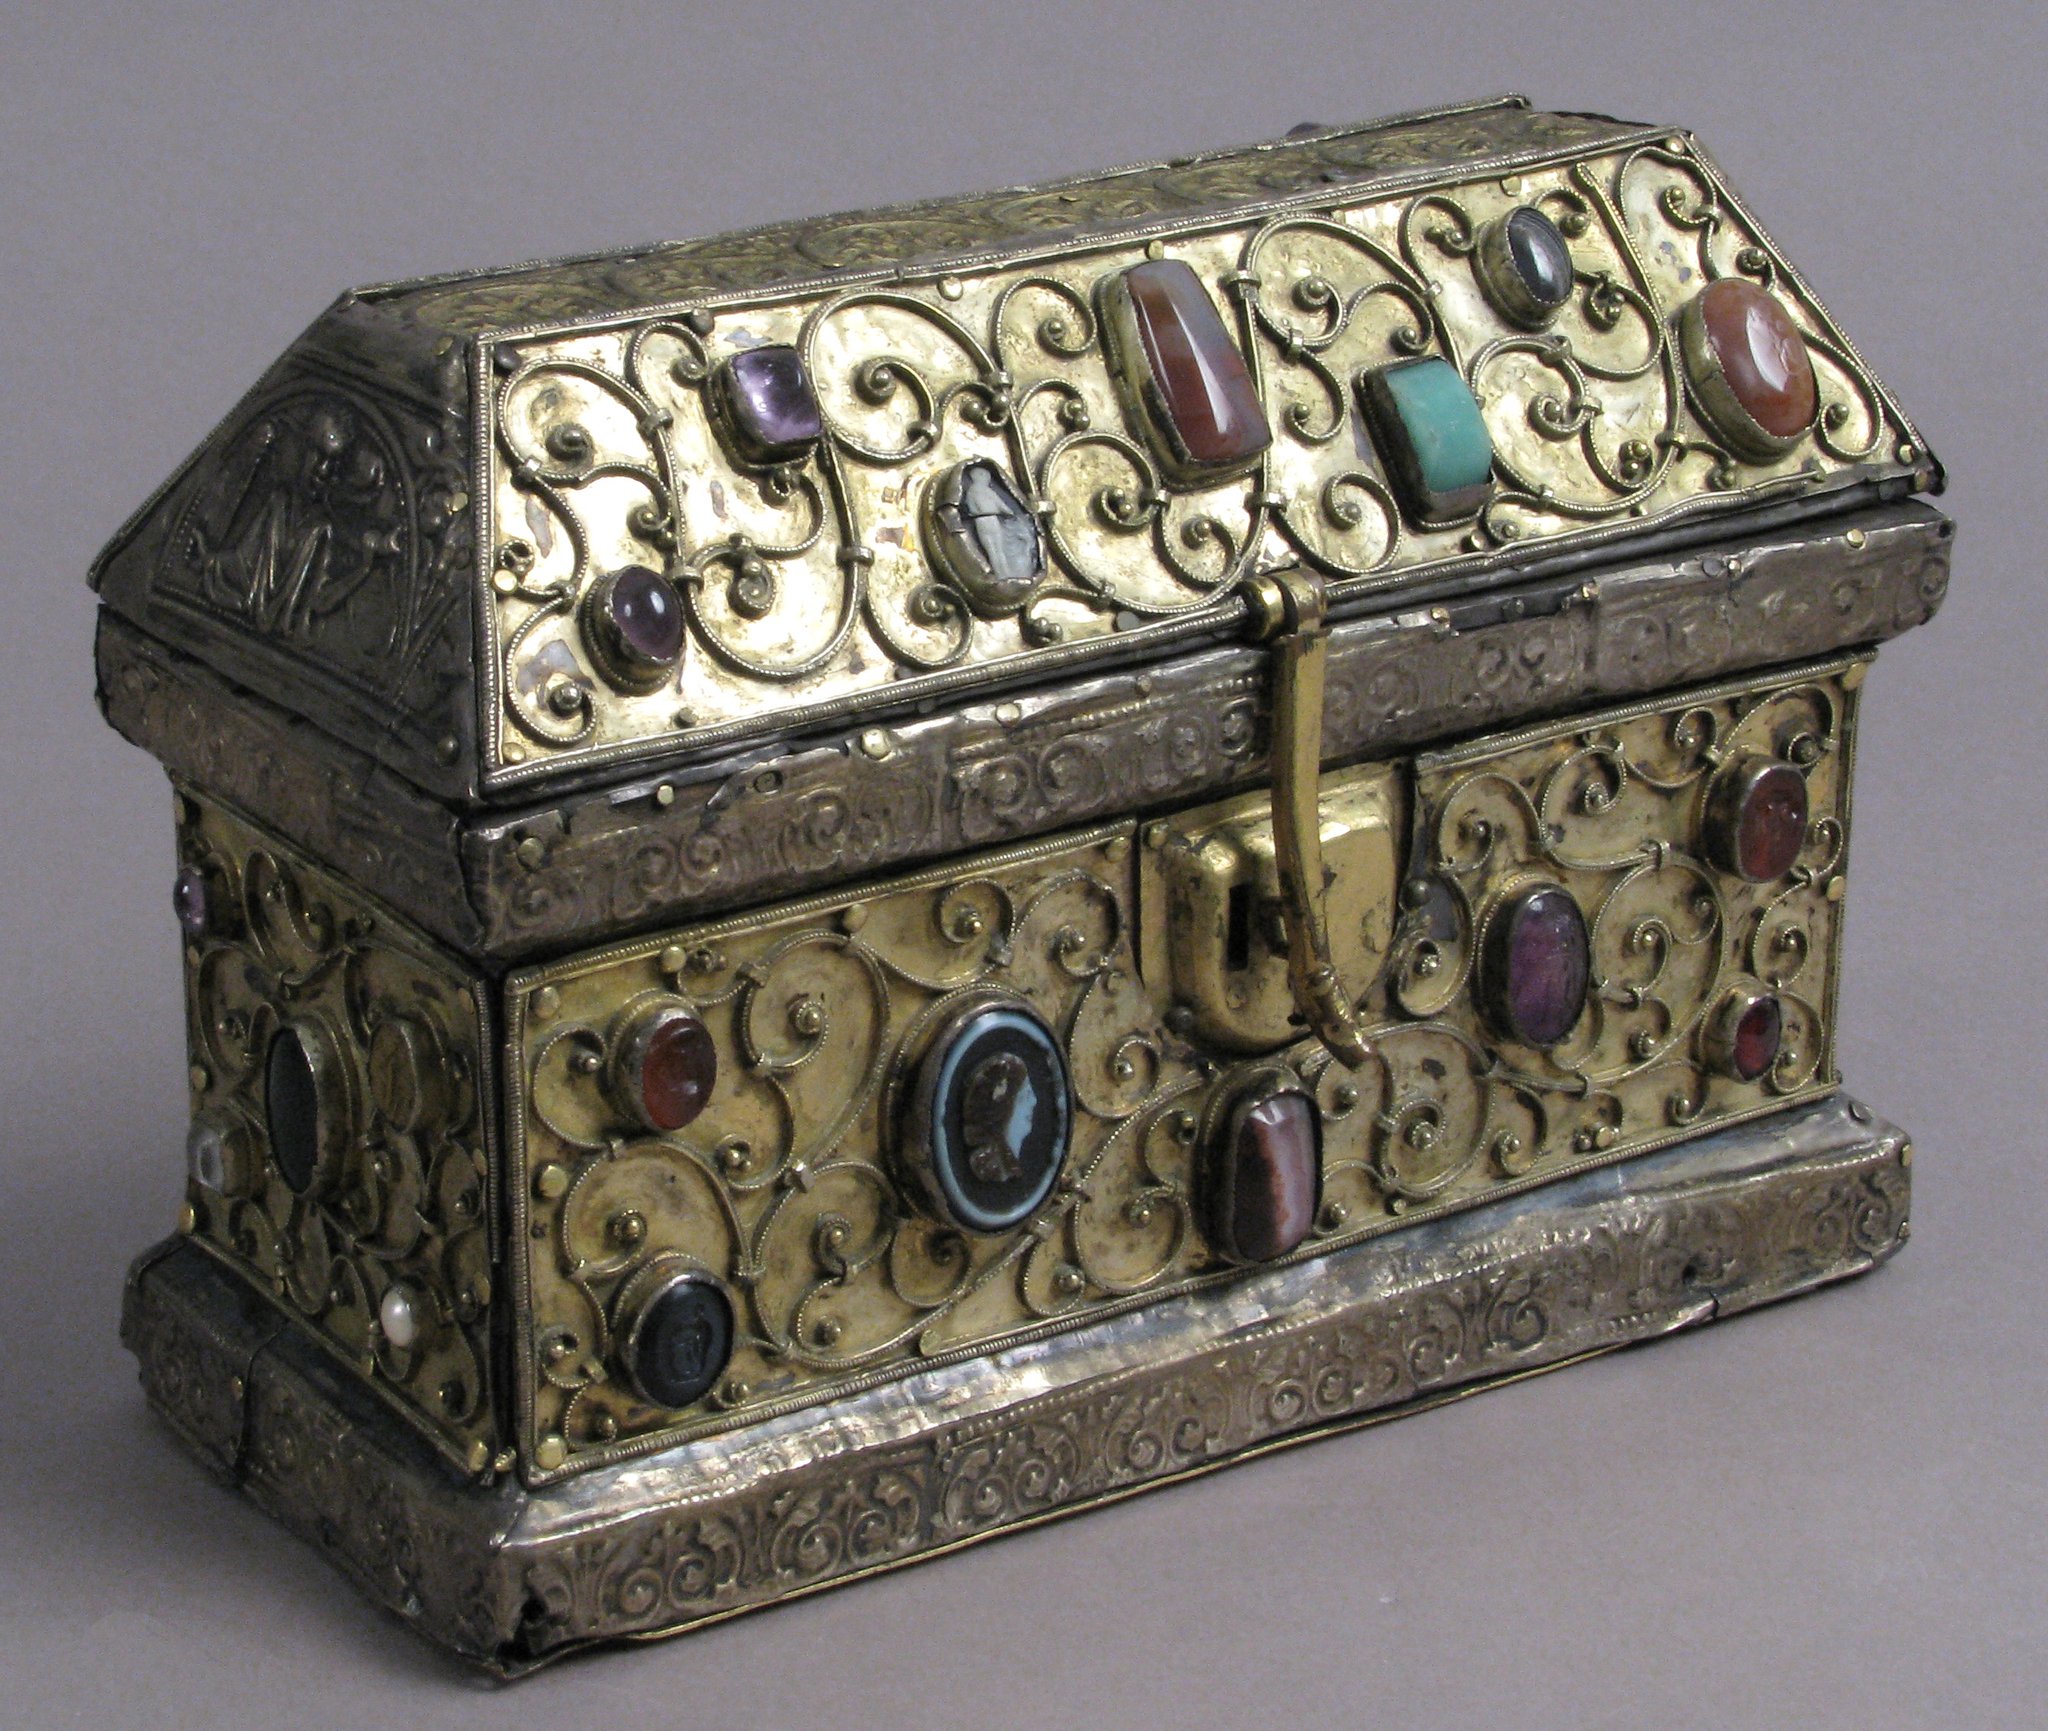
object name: chasse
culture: german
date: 1101-1200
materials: silver gilt, wood